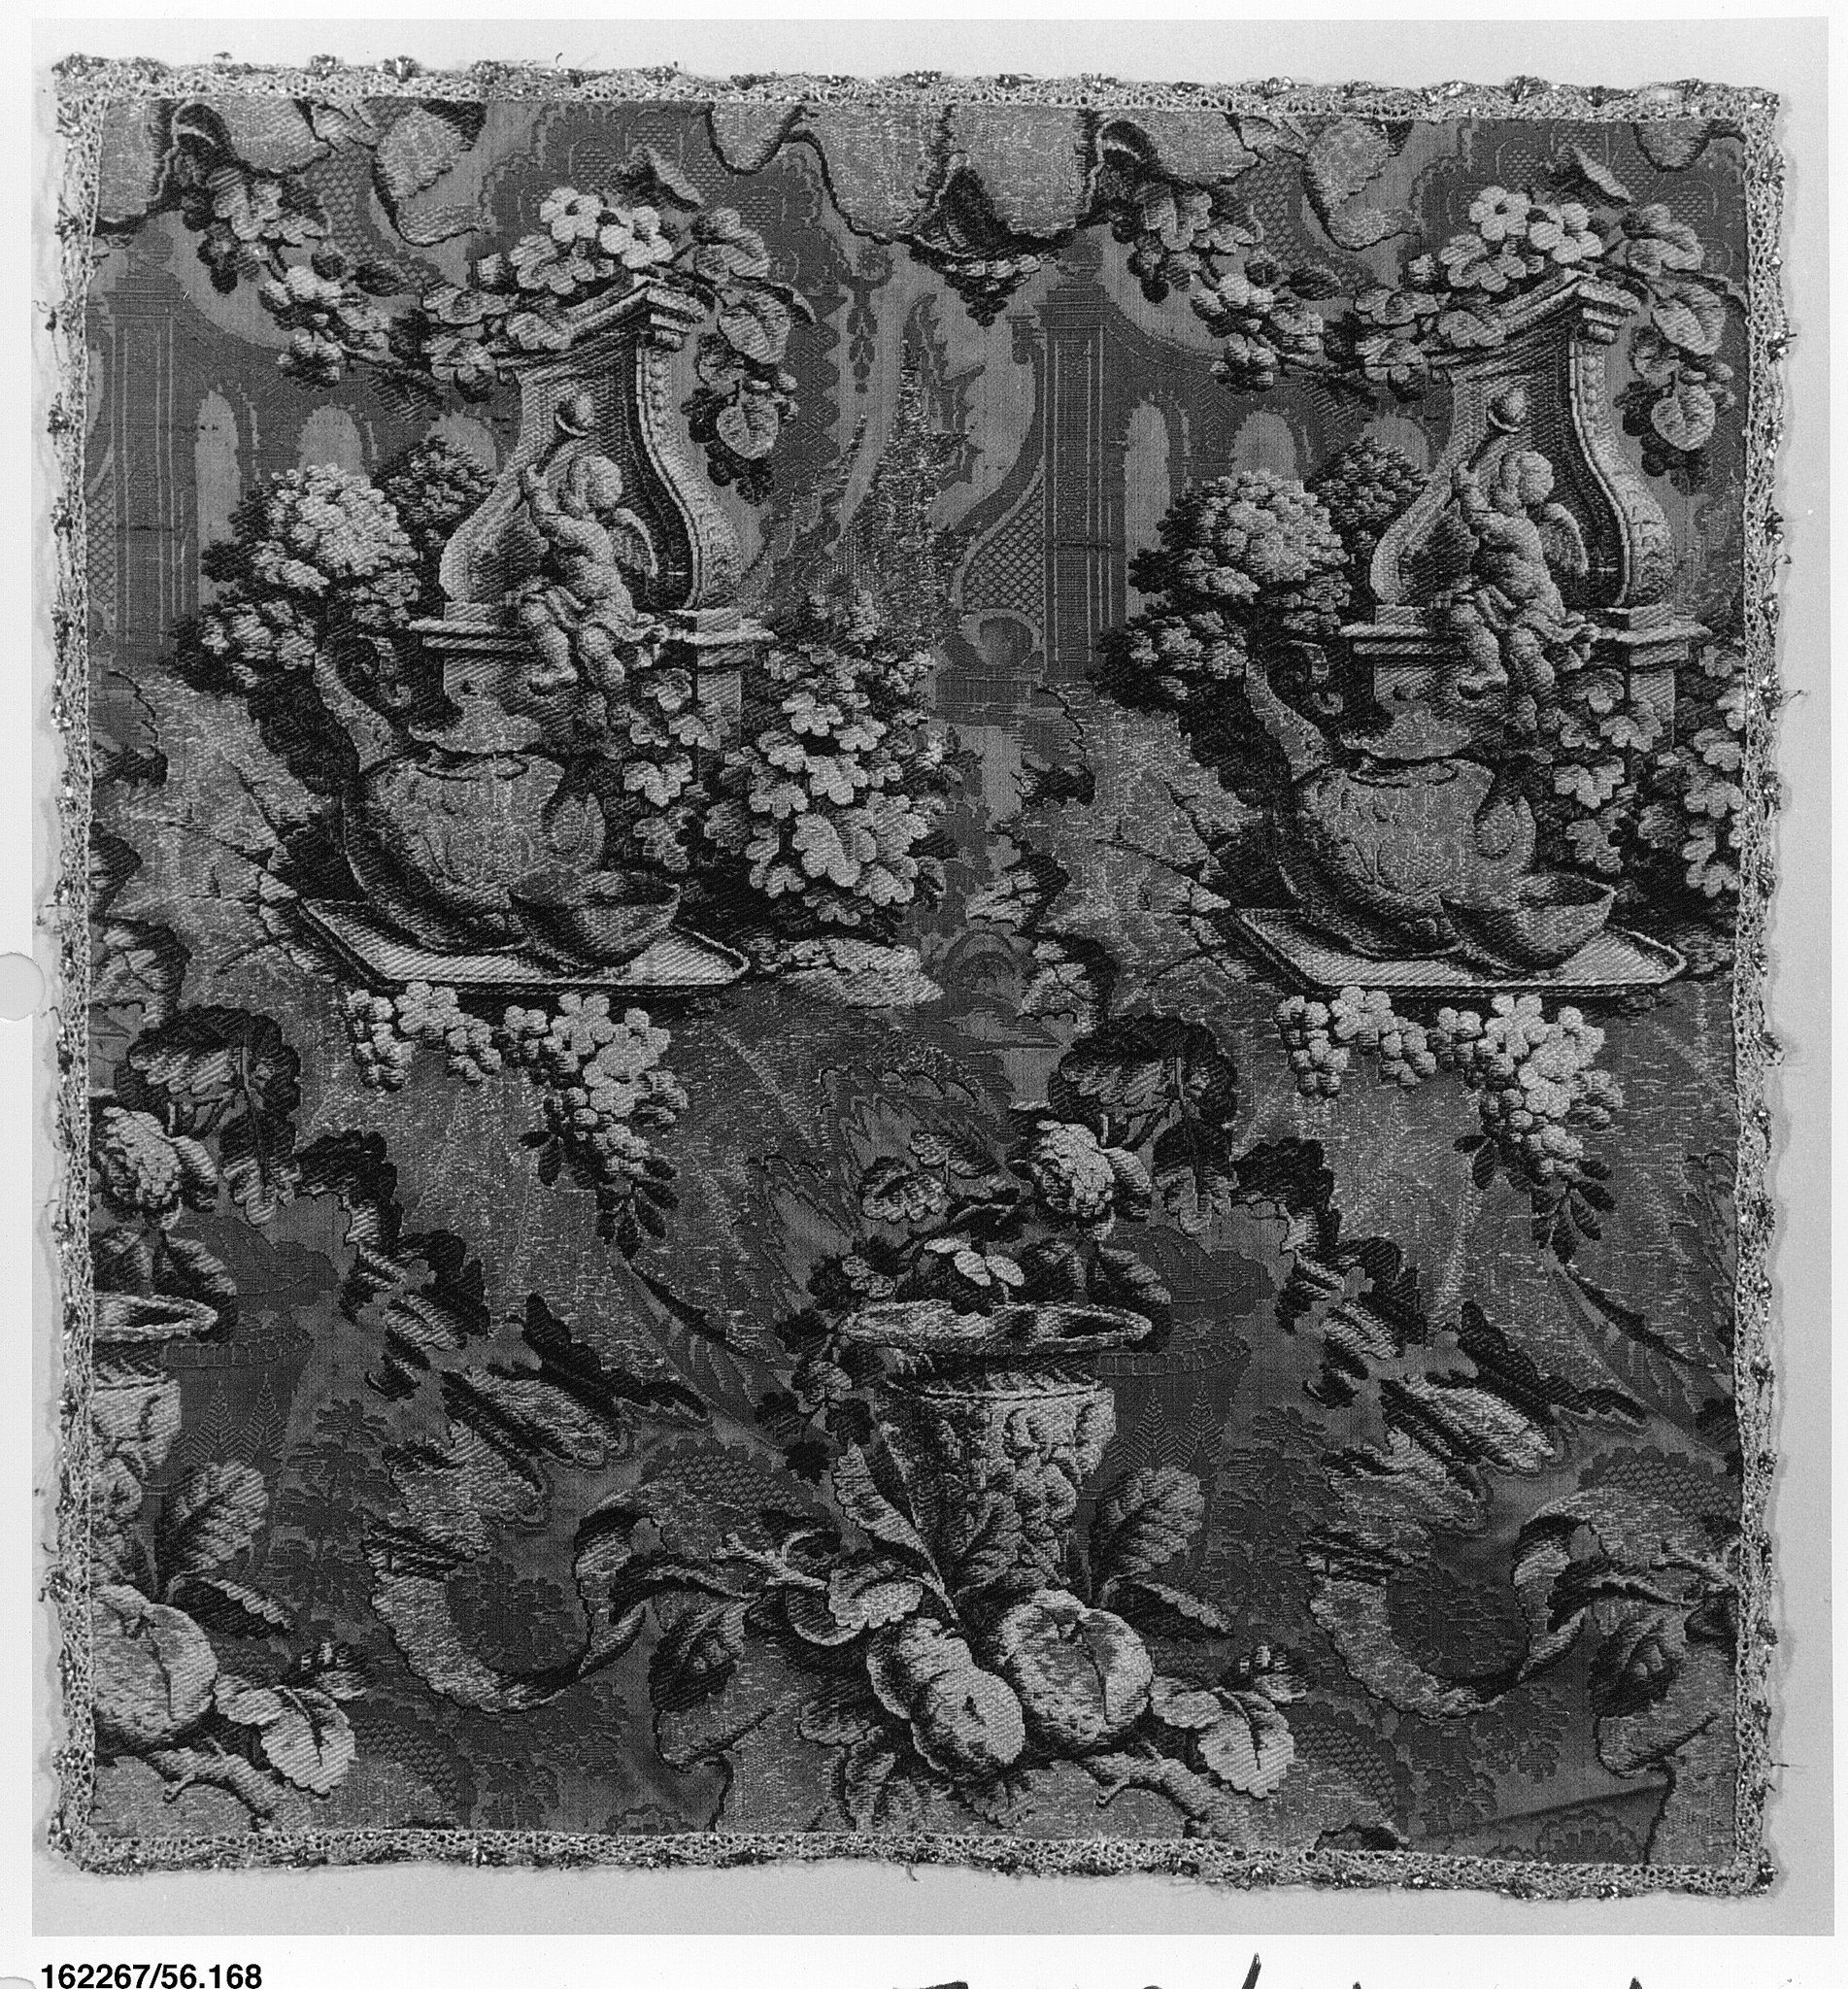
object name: piece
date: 1735-1740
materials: metal thread, silk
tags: cupid,flowers